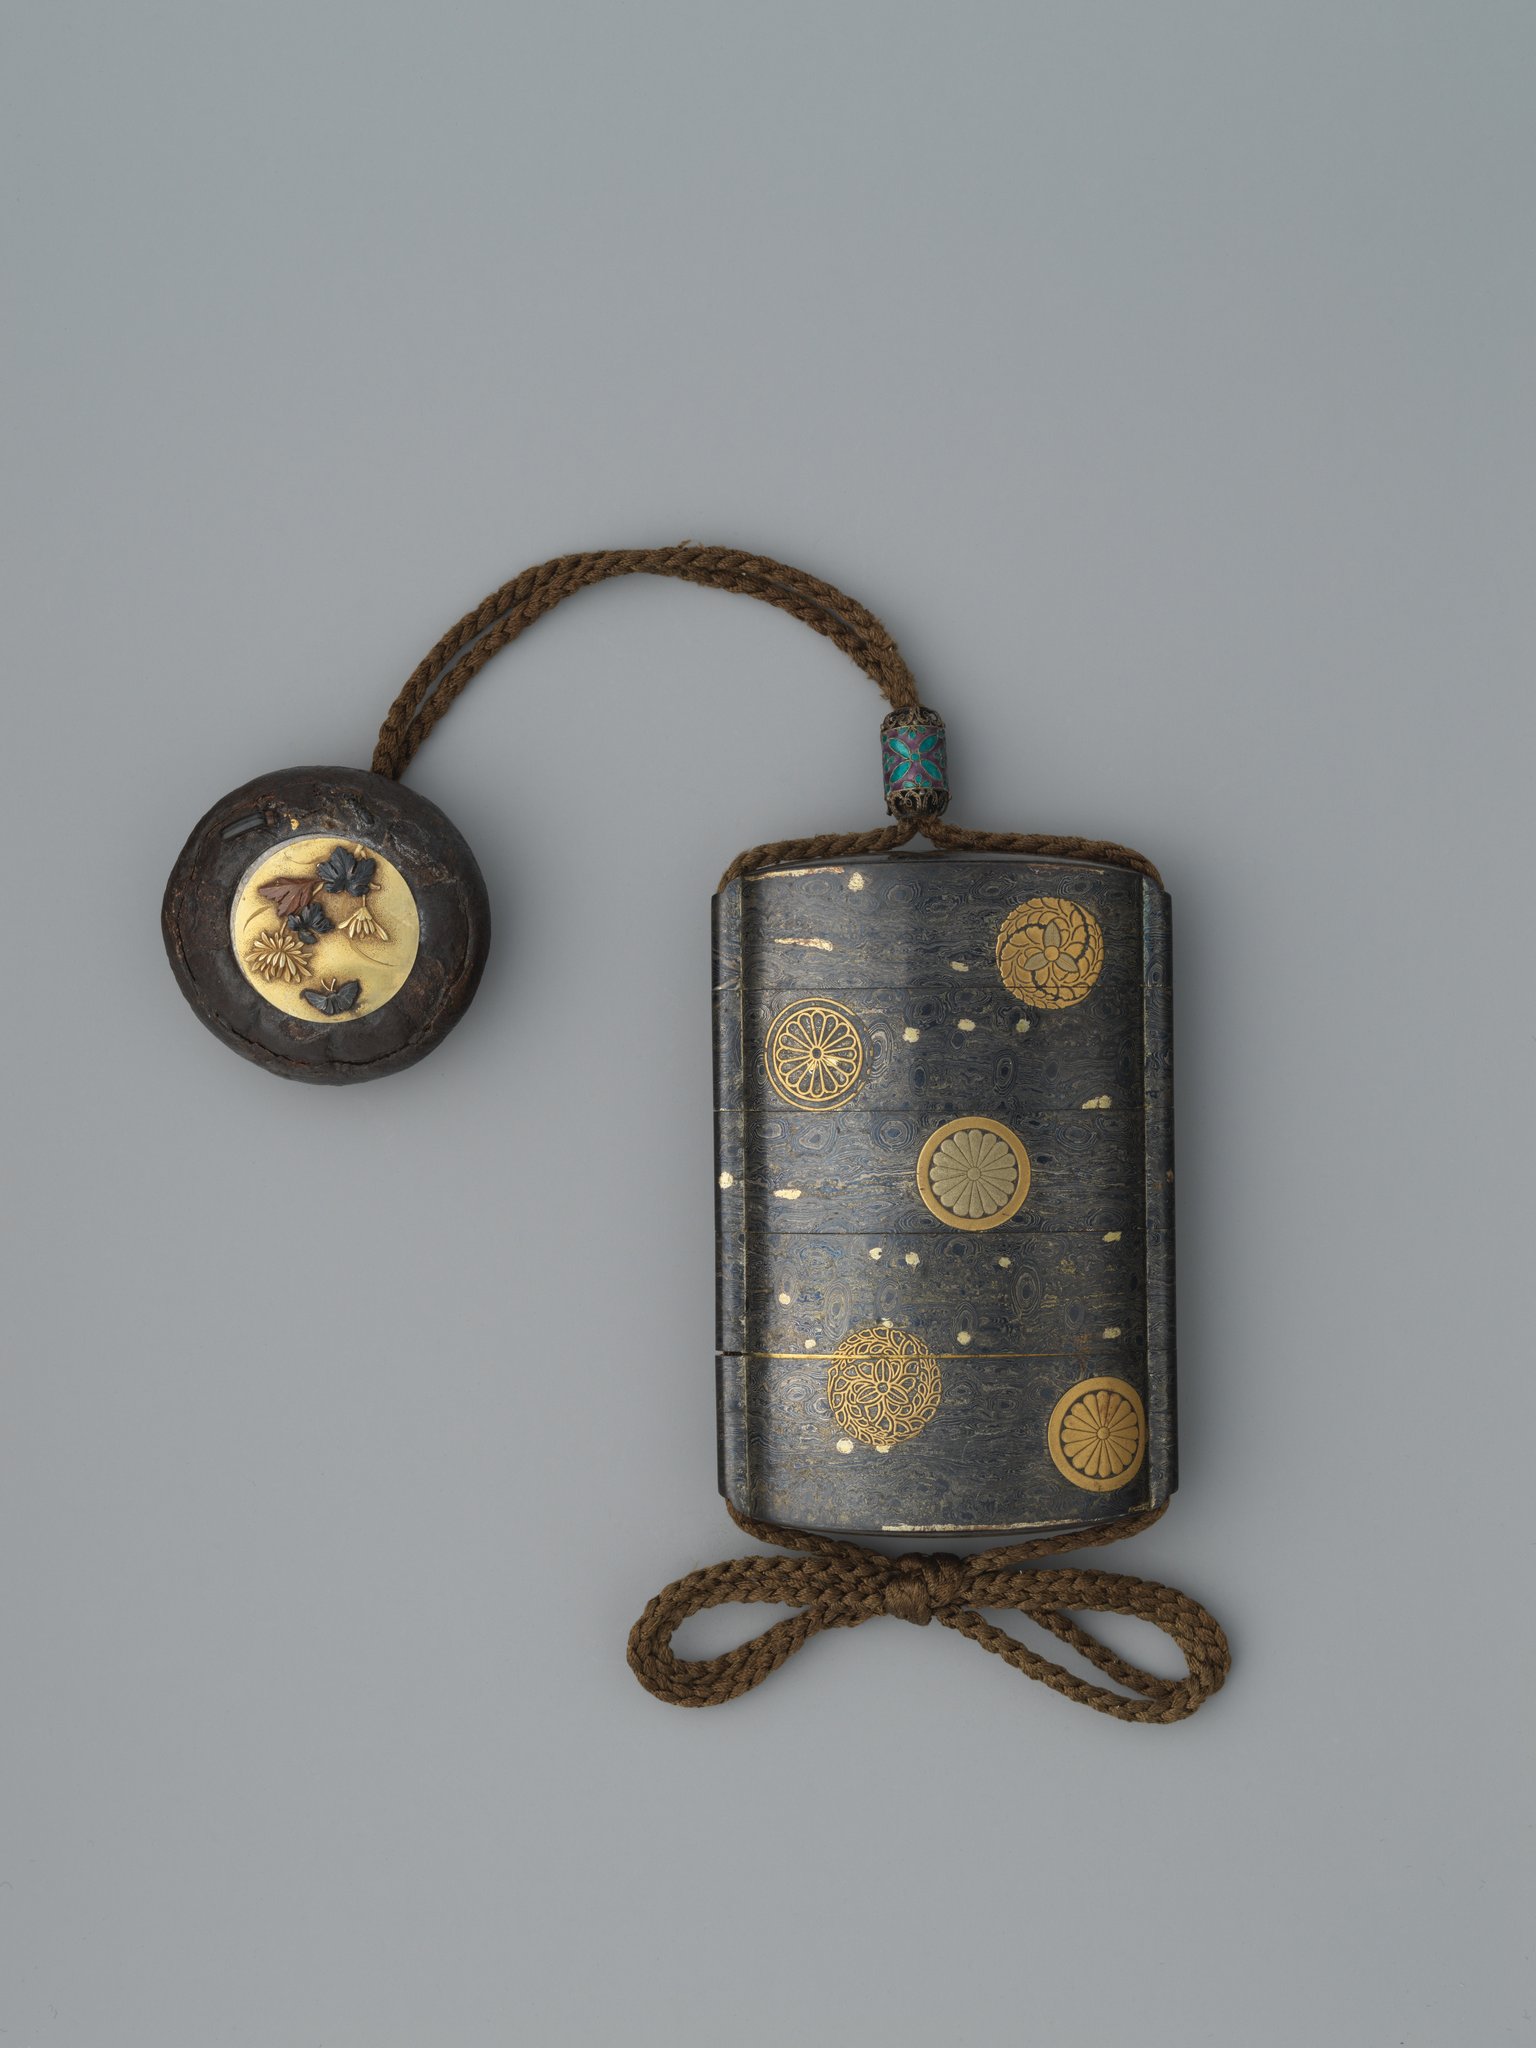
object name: inrō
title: Metal Inrō with Flower Medallions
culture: japanese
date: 1834-1866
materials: gold, metal, silver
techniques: enamel, hiramakie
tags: flowers